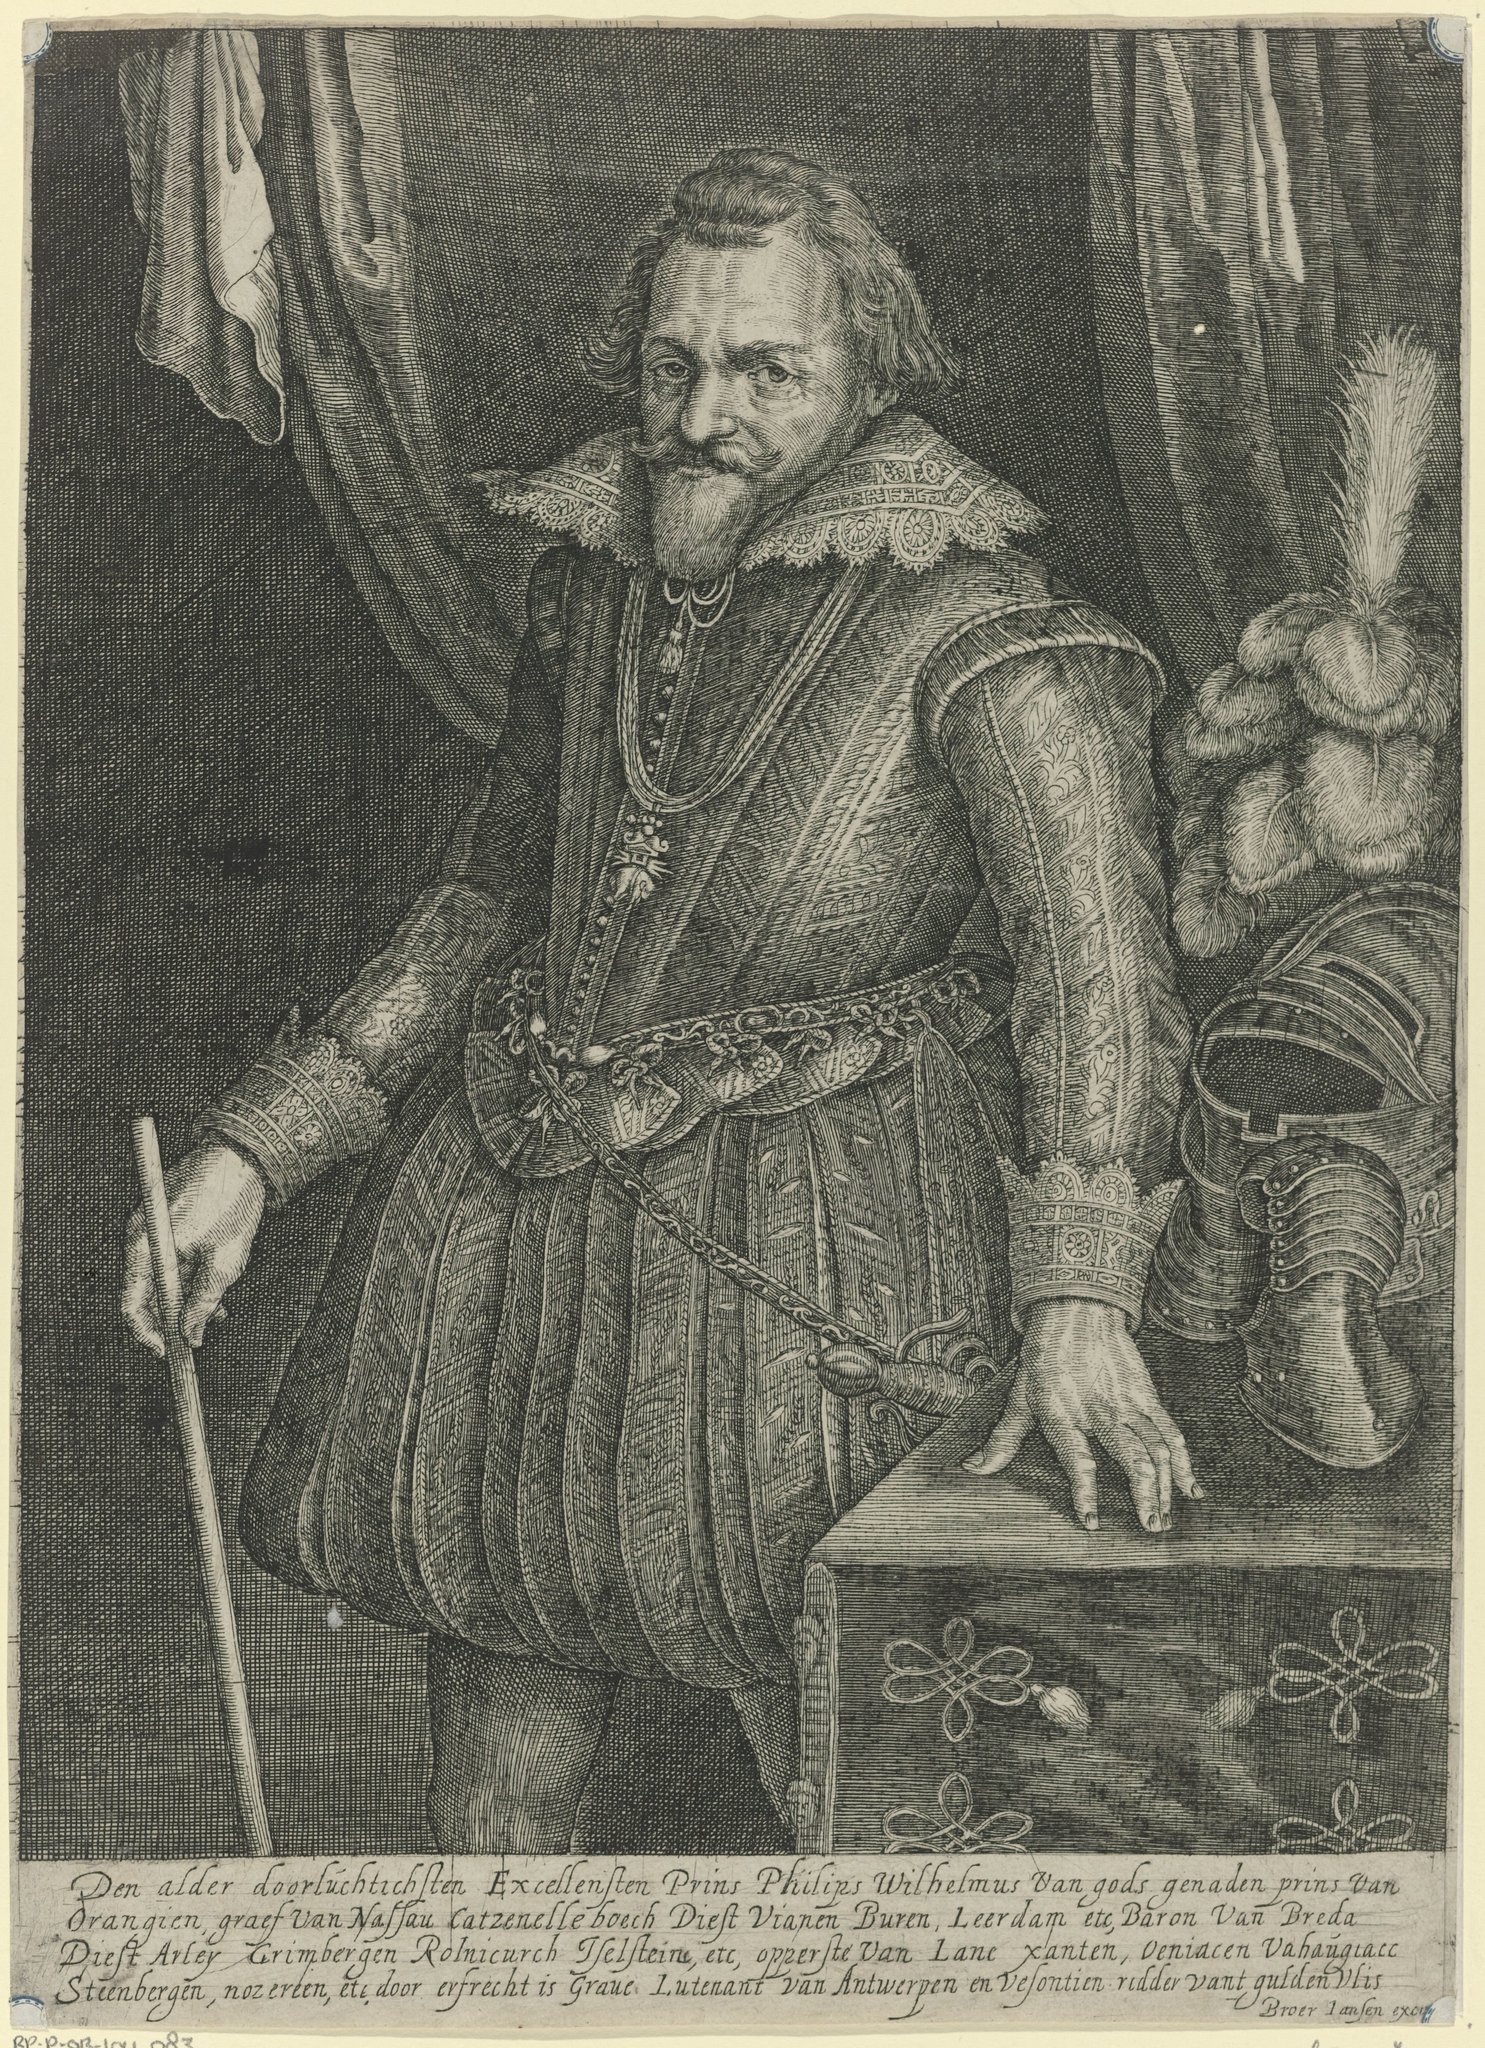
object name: print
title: Portret van Filips Willem, prins van Oranje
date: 1586-1629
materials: paper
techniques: engraving, etching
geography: low countries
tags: bruges, filips willem (prins van oranje), knighthood order of the golden fleece - insignia of a knighthood order, e.g.: badge, chain (with name of order)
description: Portret van Filips Willem. Hij staat in een vertrek naast een tafel, daarop de handschoenen en helm van zijn harnas. Hij houdt een commandostaf in de hand. In de ondermarge vier regels Nederlandse tekst.